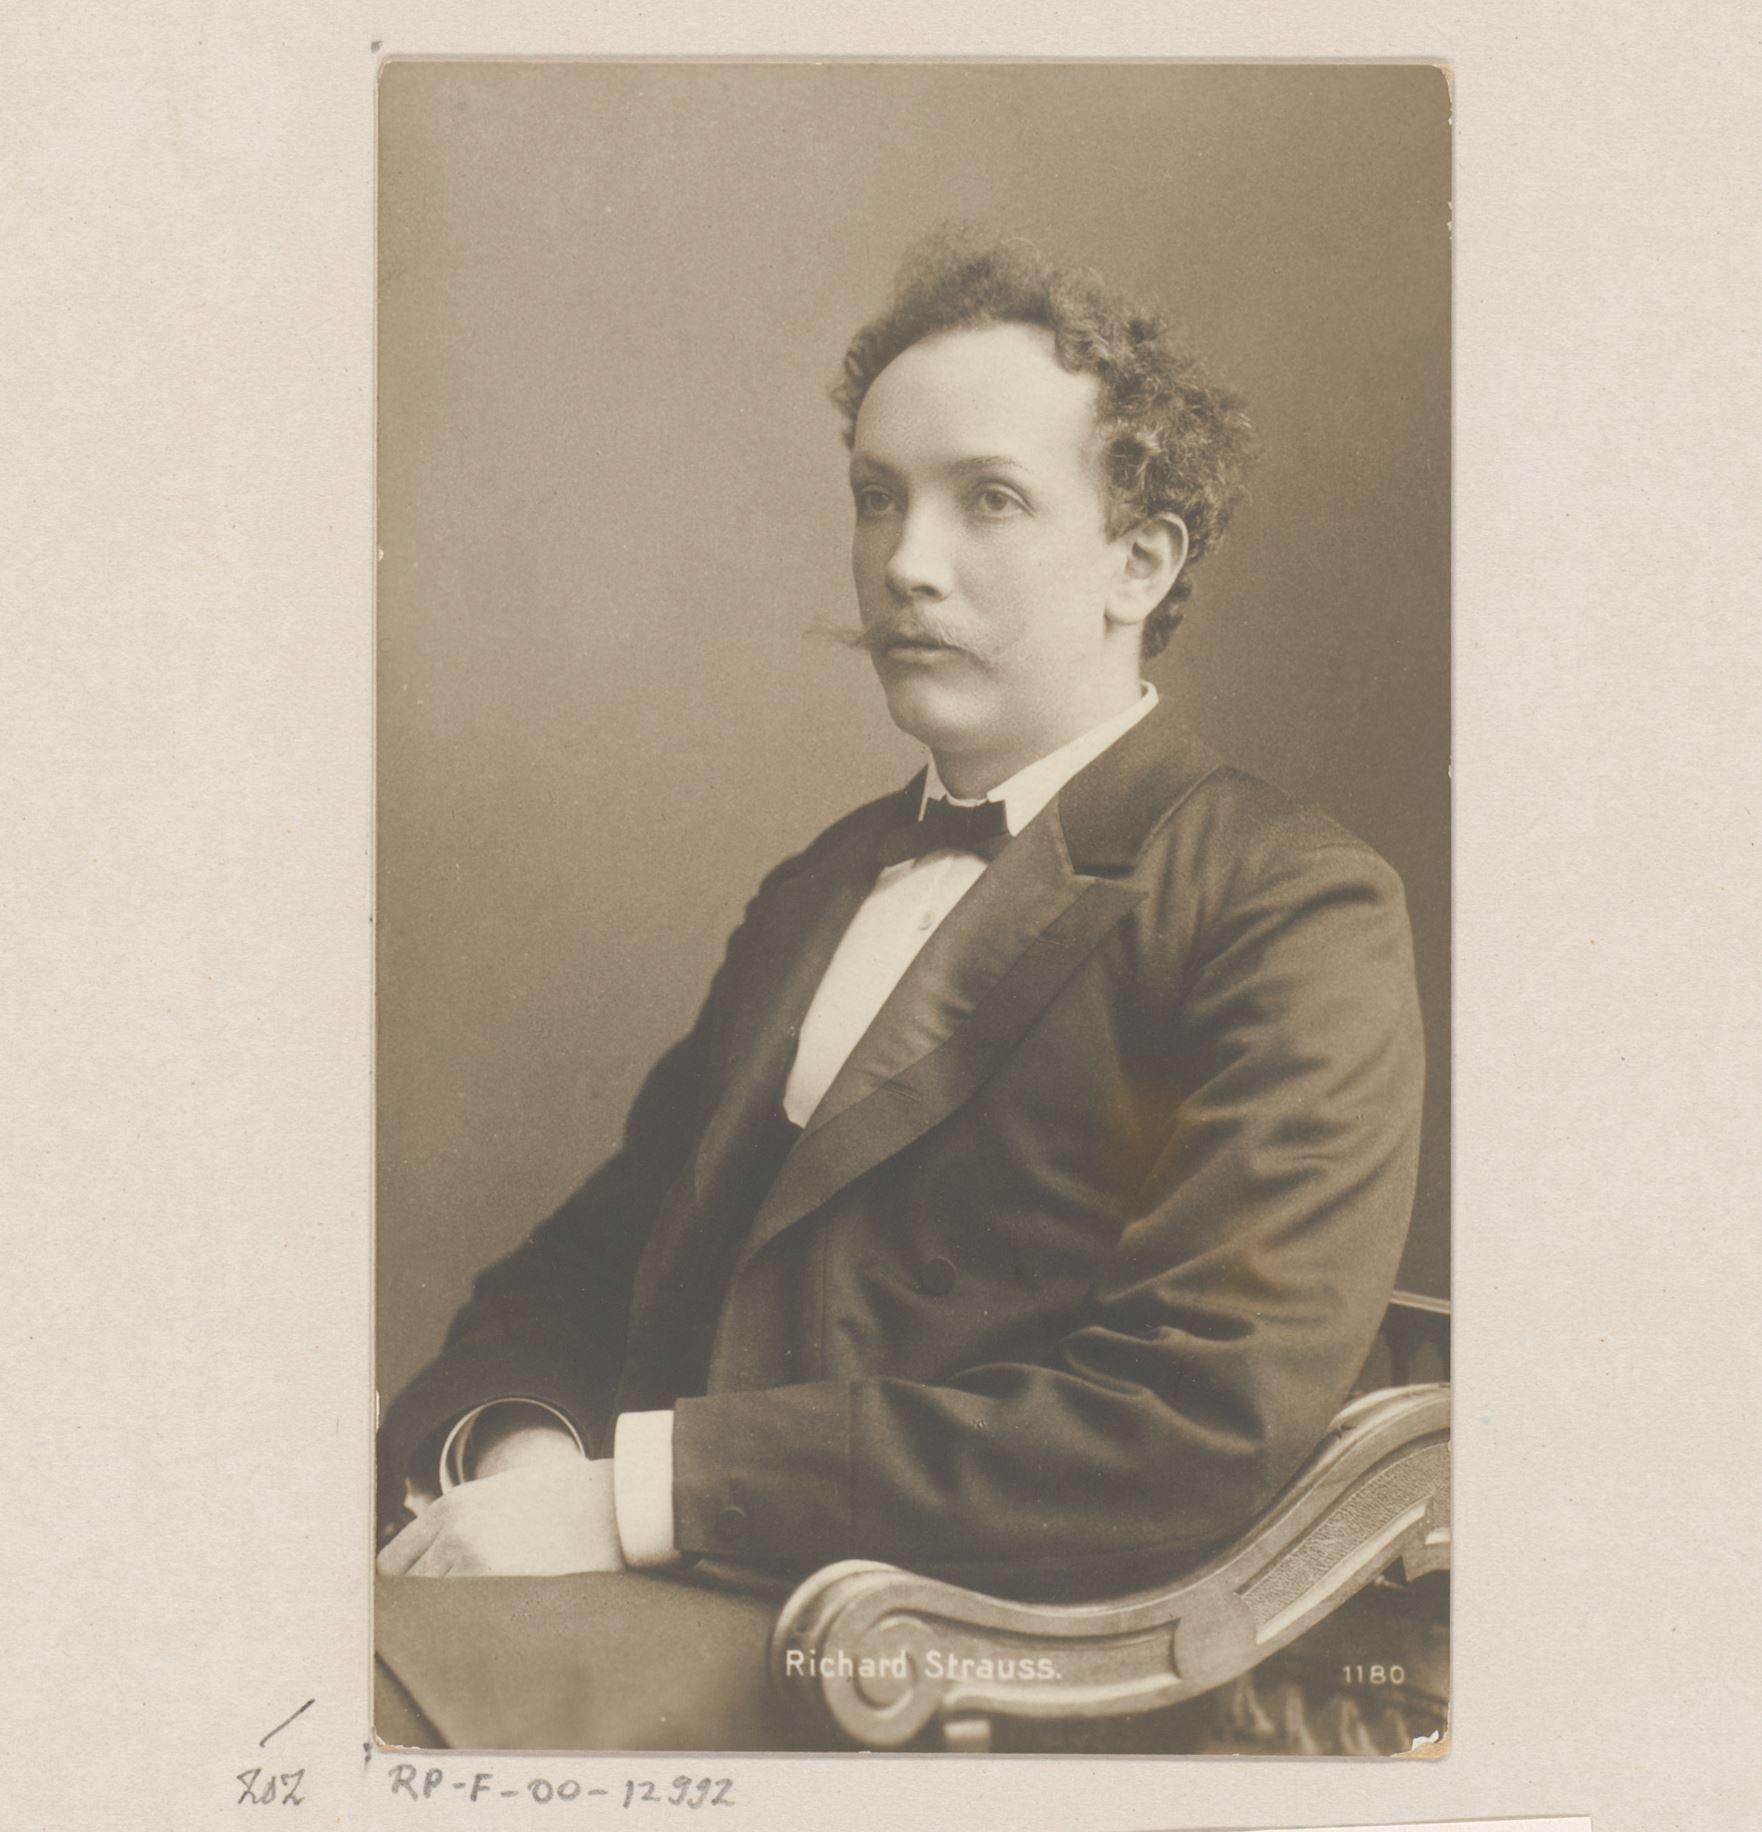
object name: photograph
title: Richard Strauss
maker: Anonymous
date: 1890-1905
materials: paper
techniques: gelatin silver print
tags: historical persons, portrait of composer